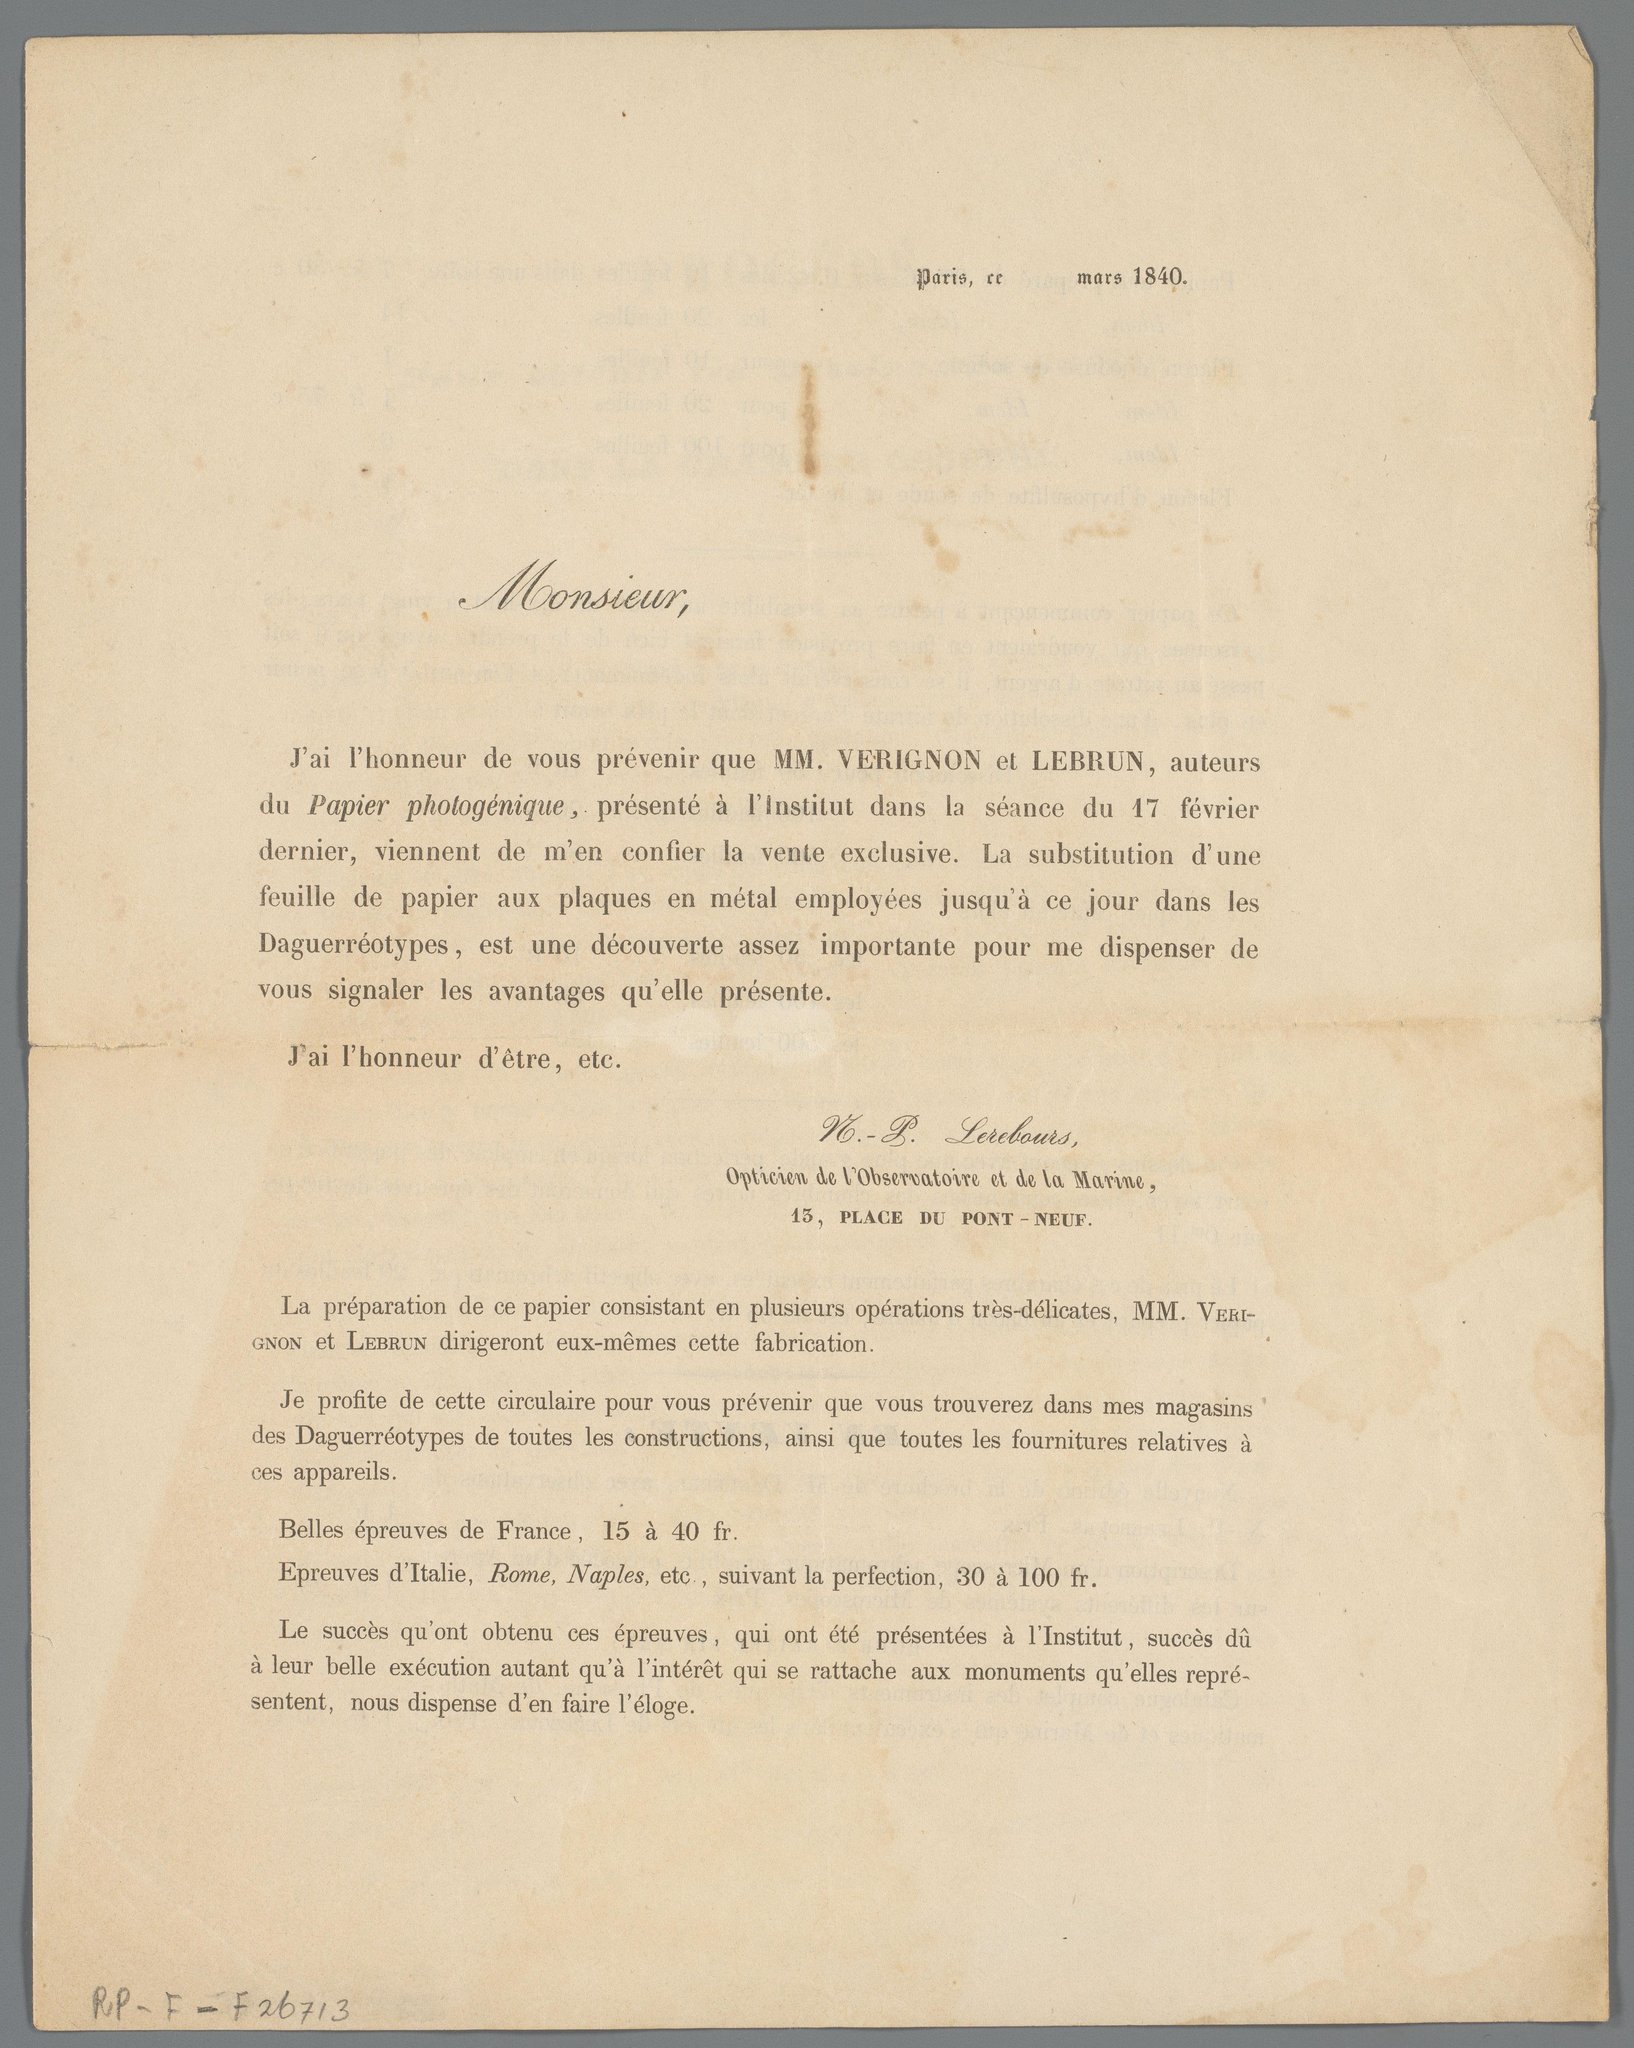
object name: brochure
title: Brochure met aanbieding van lichtgevoelig fotopapier volgens de methode van Verignon & Lebrun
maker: noël marie paymal lerebours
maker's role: instrument maker, publisher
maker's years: 1807-1873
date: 1803-1840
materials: ink, paper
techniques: letterpress printing, pen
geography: paris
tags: advertisement, notice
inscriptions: inscription: ‘(1) Il est essentiel avant de (...)’, address: ‘N.-P. Lerebours,/ Opticien de l'Observatoire et de la Marine,/ 13, PLACE DU PONT-NEUF.’